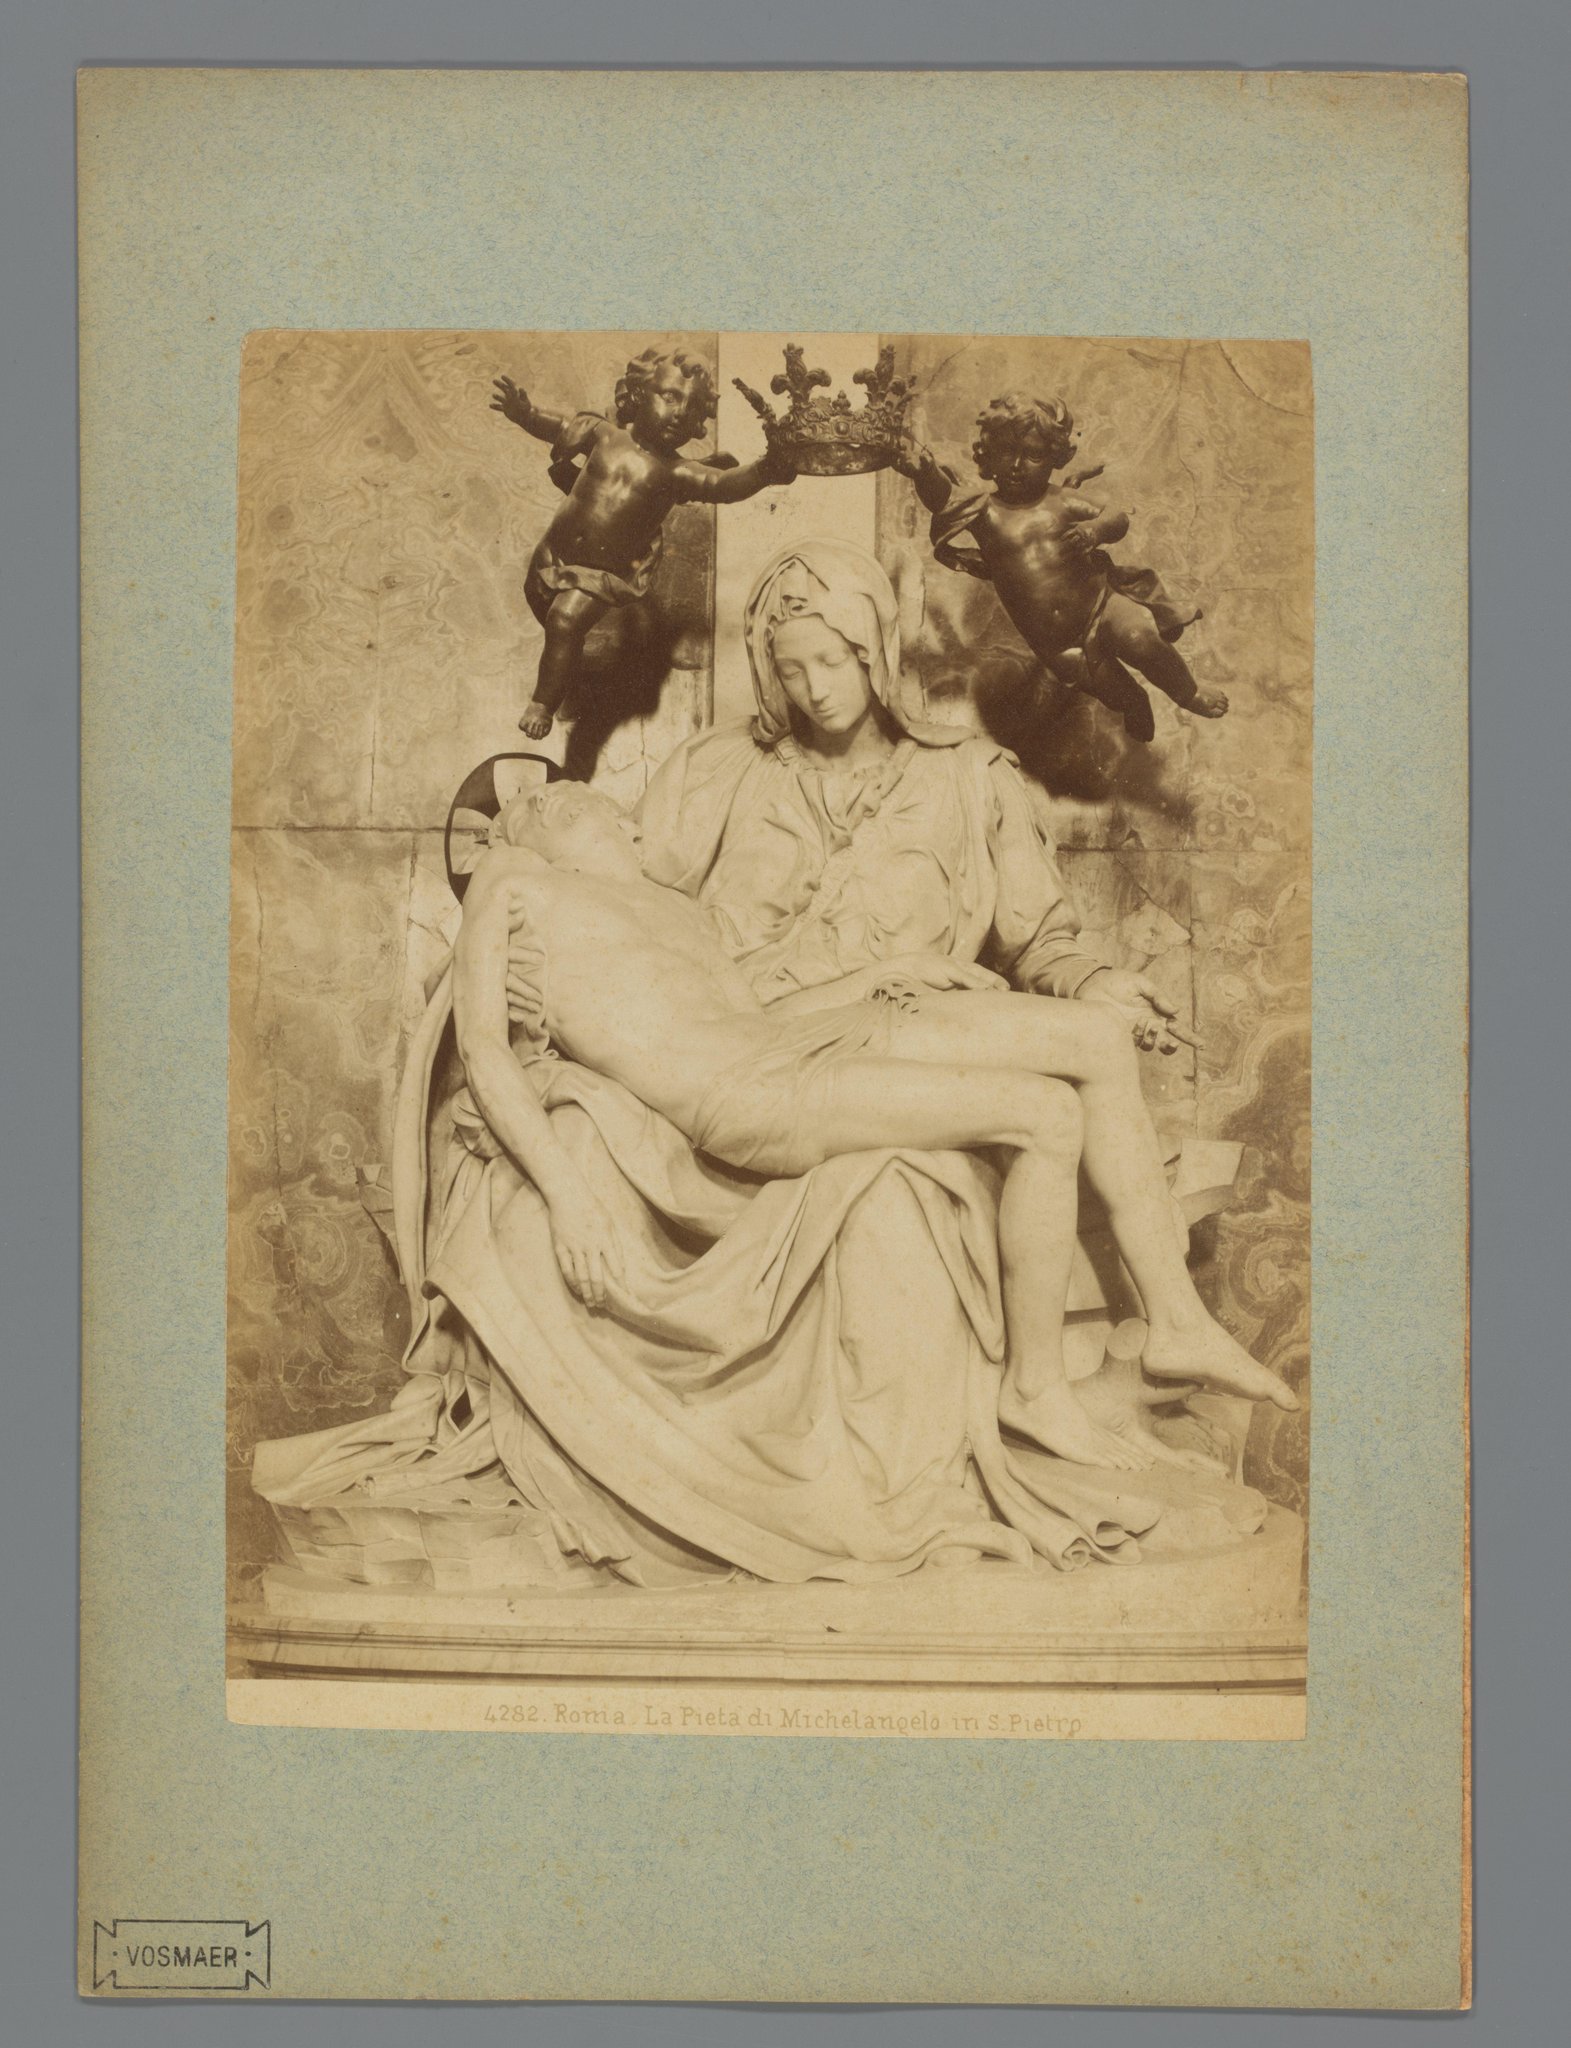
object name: photograph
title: Roma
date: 1851-1890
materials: cardboard, paper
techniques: albumen print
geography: rome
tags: adult christ with mary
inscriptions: inscription: ‘doubl’, collector's mark: ‘VOSMAER’, number: ‘4282.’